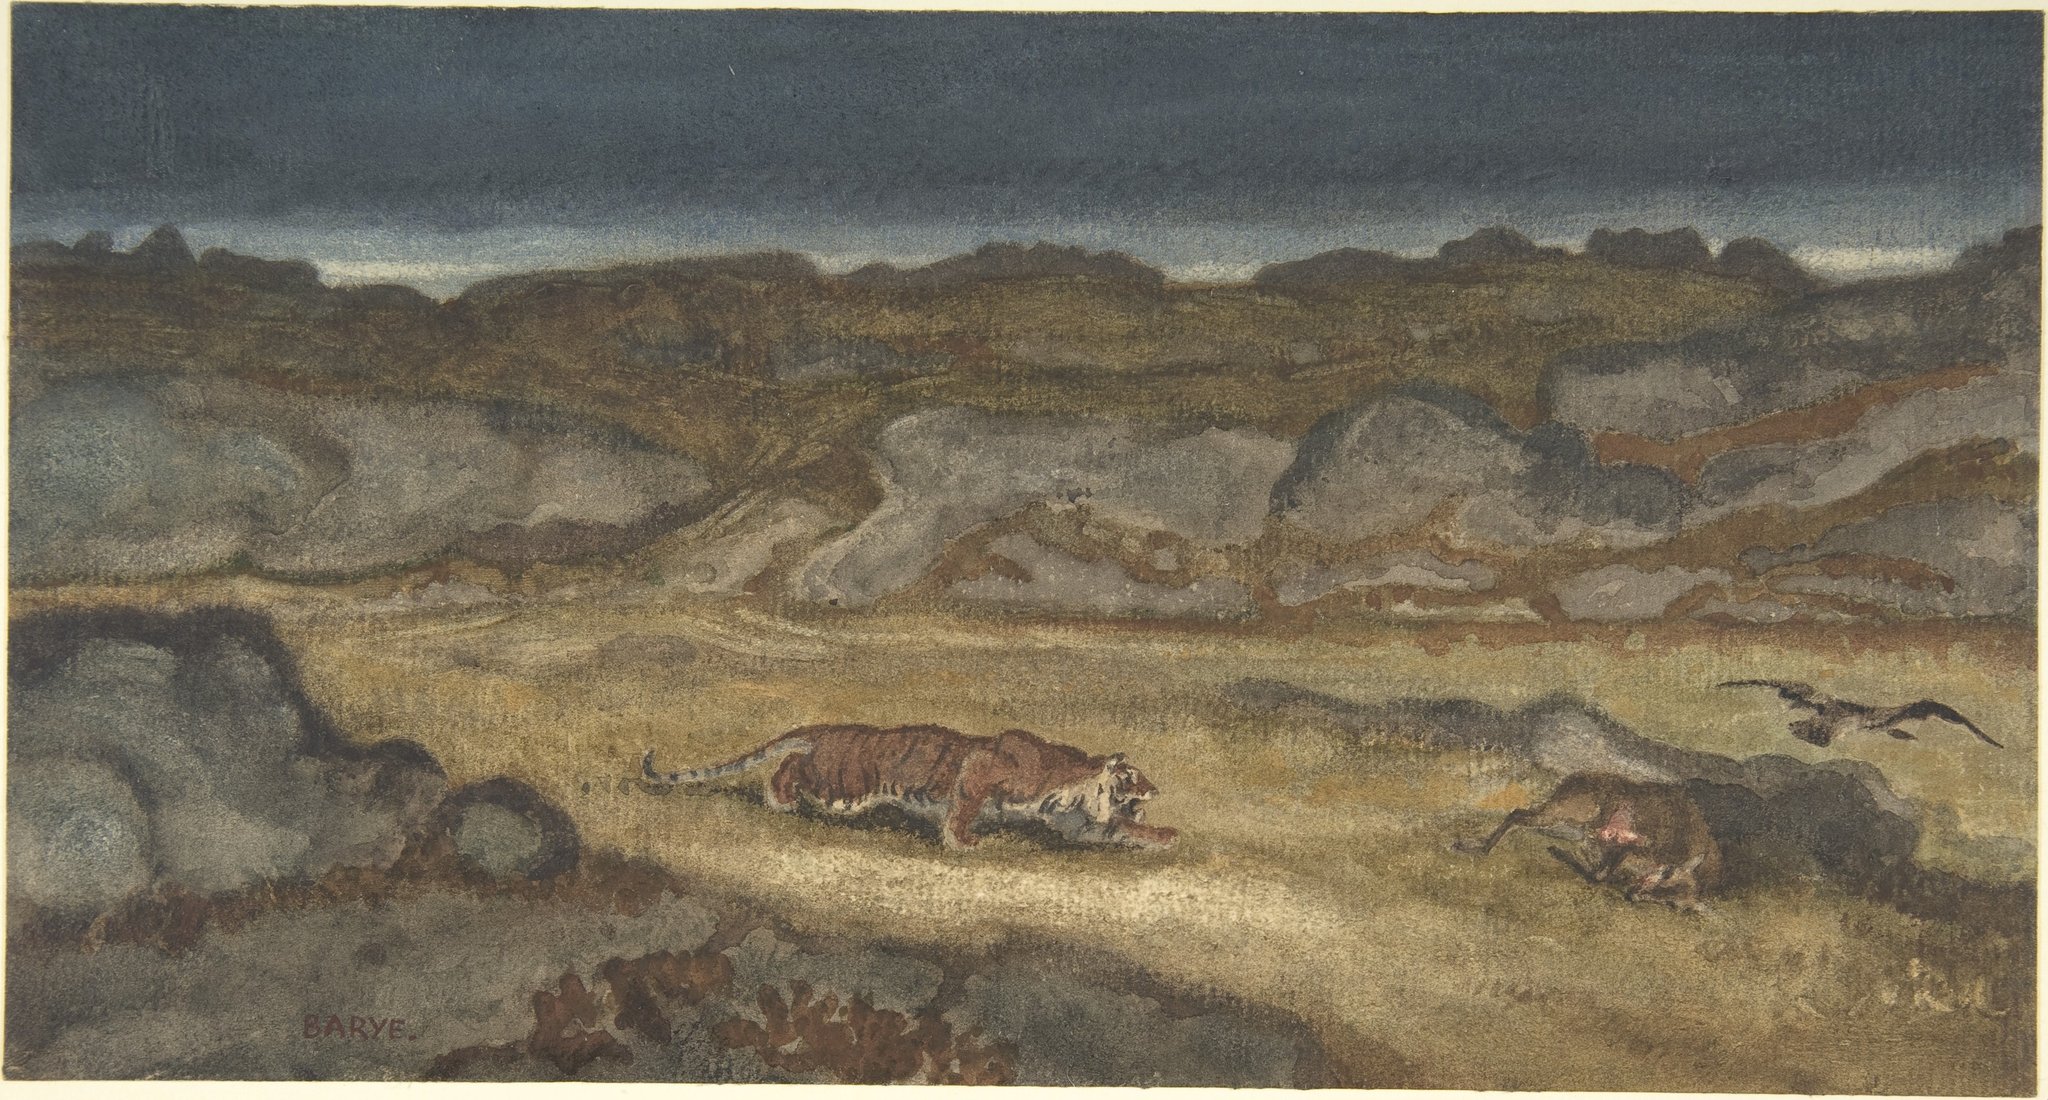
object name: drawing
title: Tiger Stalking Prey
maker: antoine-louis barye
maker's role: artist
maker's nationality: french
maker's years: 1795-1875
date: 1795-1875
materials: watercolor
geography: france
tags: birds,tigers,hills